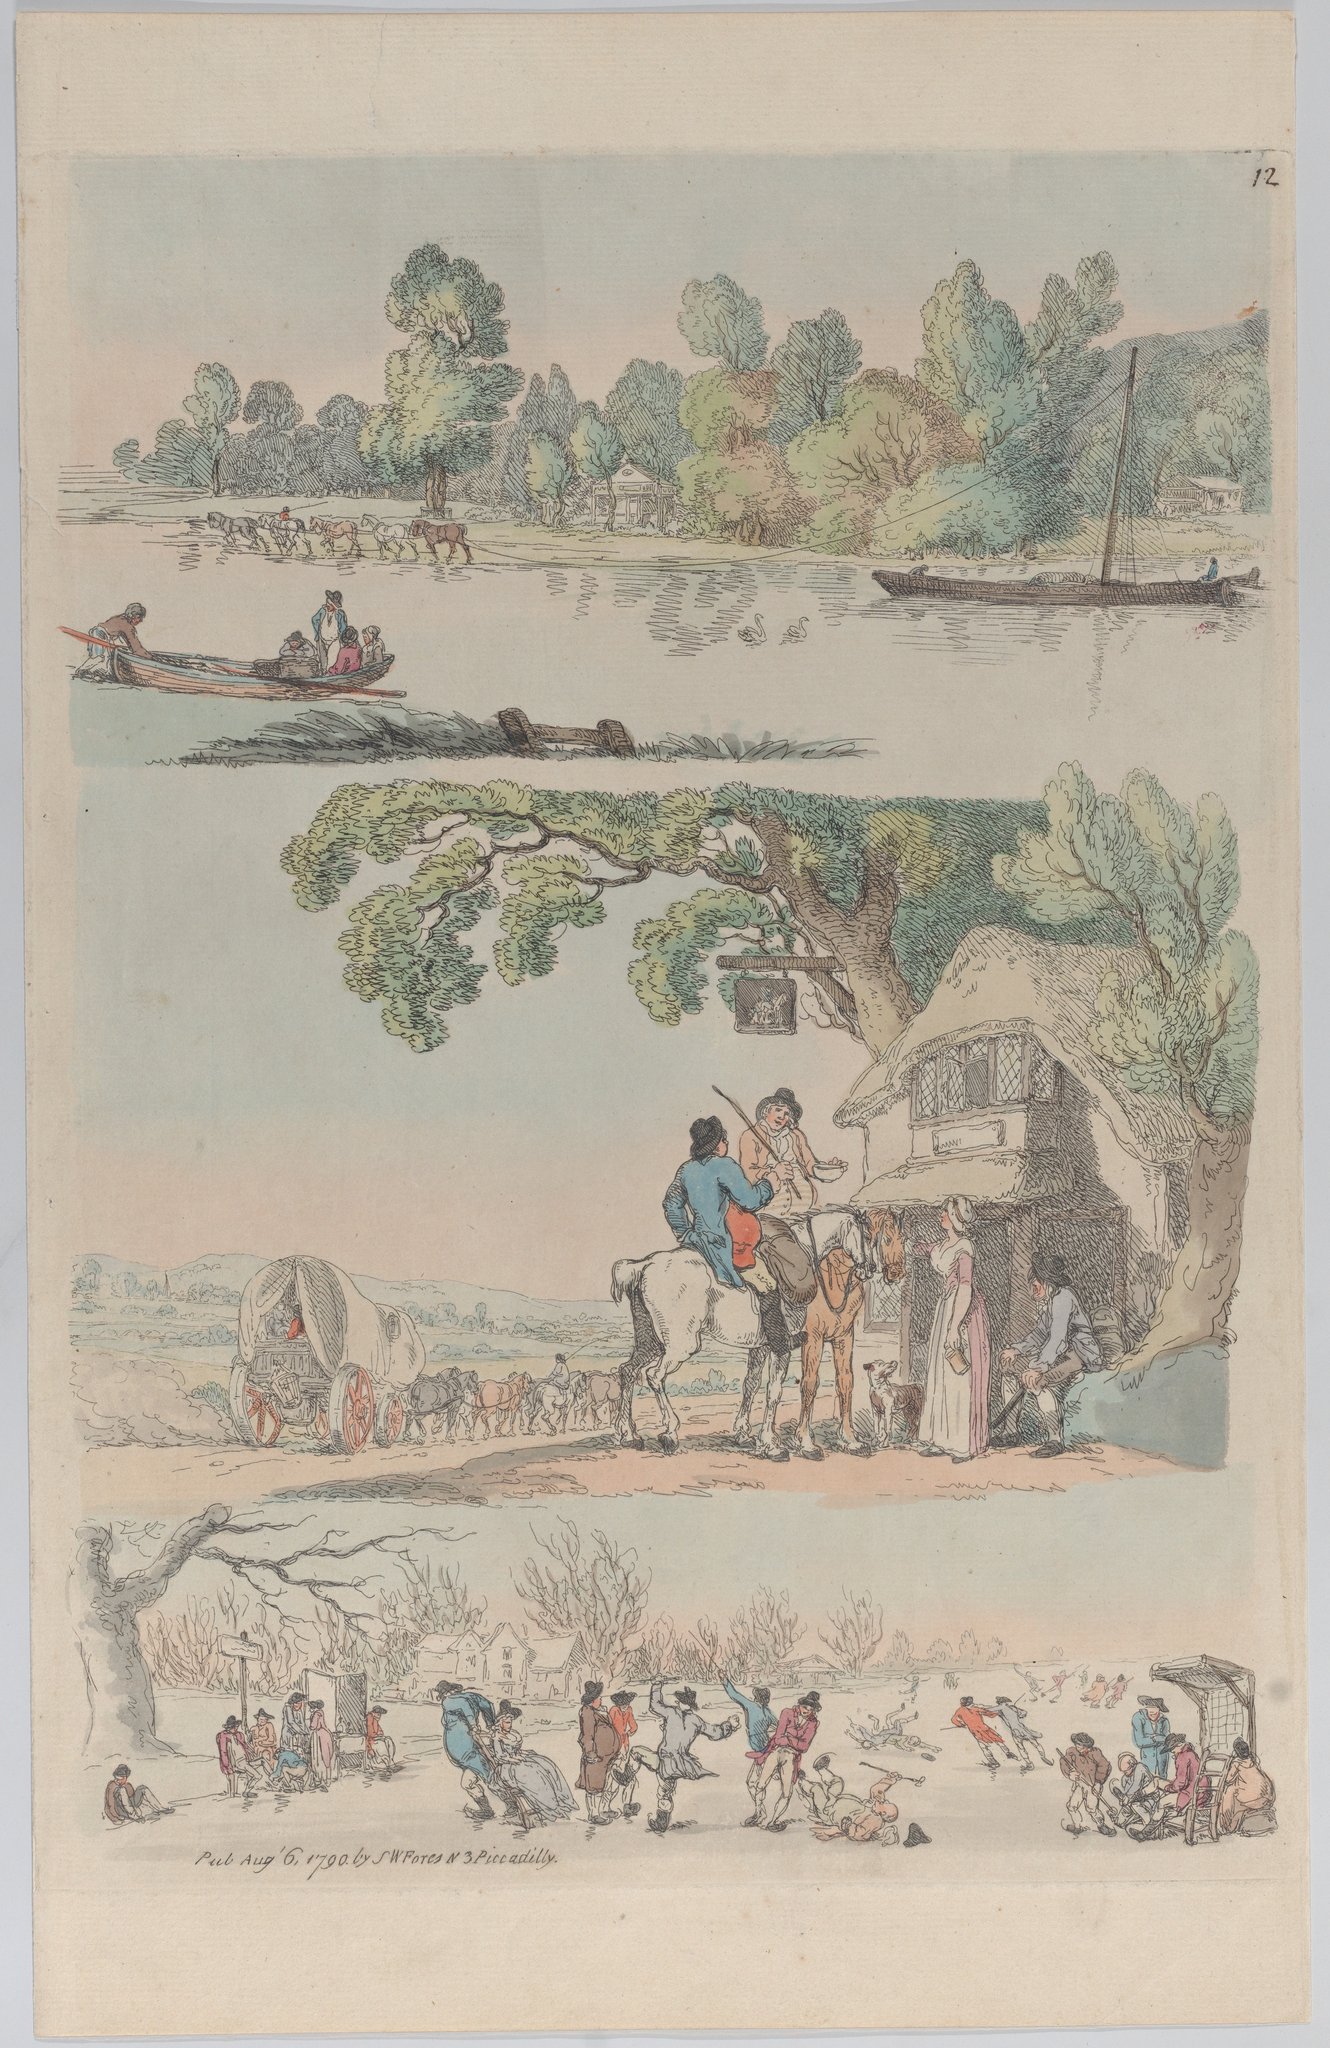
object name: print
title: Plate 12, Outlines of Figures, Landscape and Cattle...for the use of learners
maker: thomas rowlandson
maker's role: artist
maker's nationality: british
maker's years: 1757-1827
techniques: etching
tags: men,women,skating,horses,rivers,boats